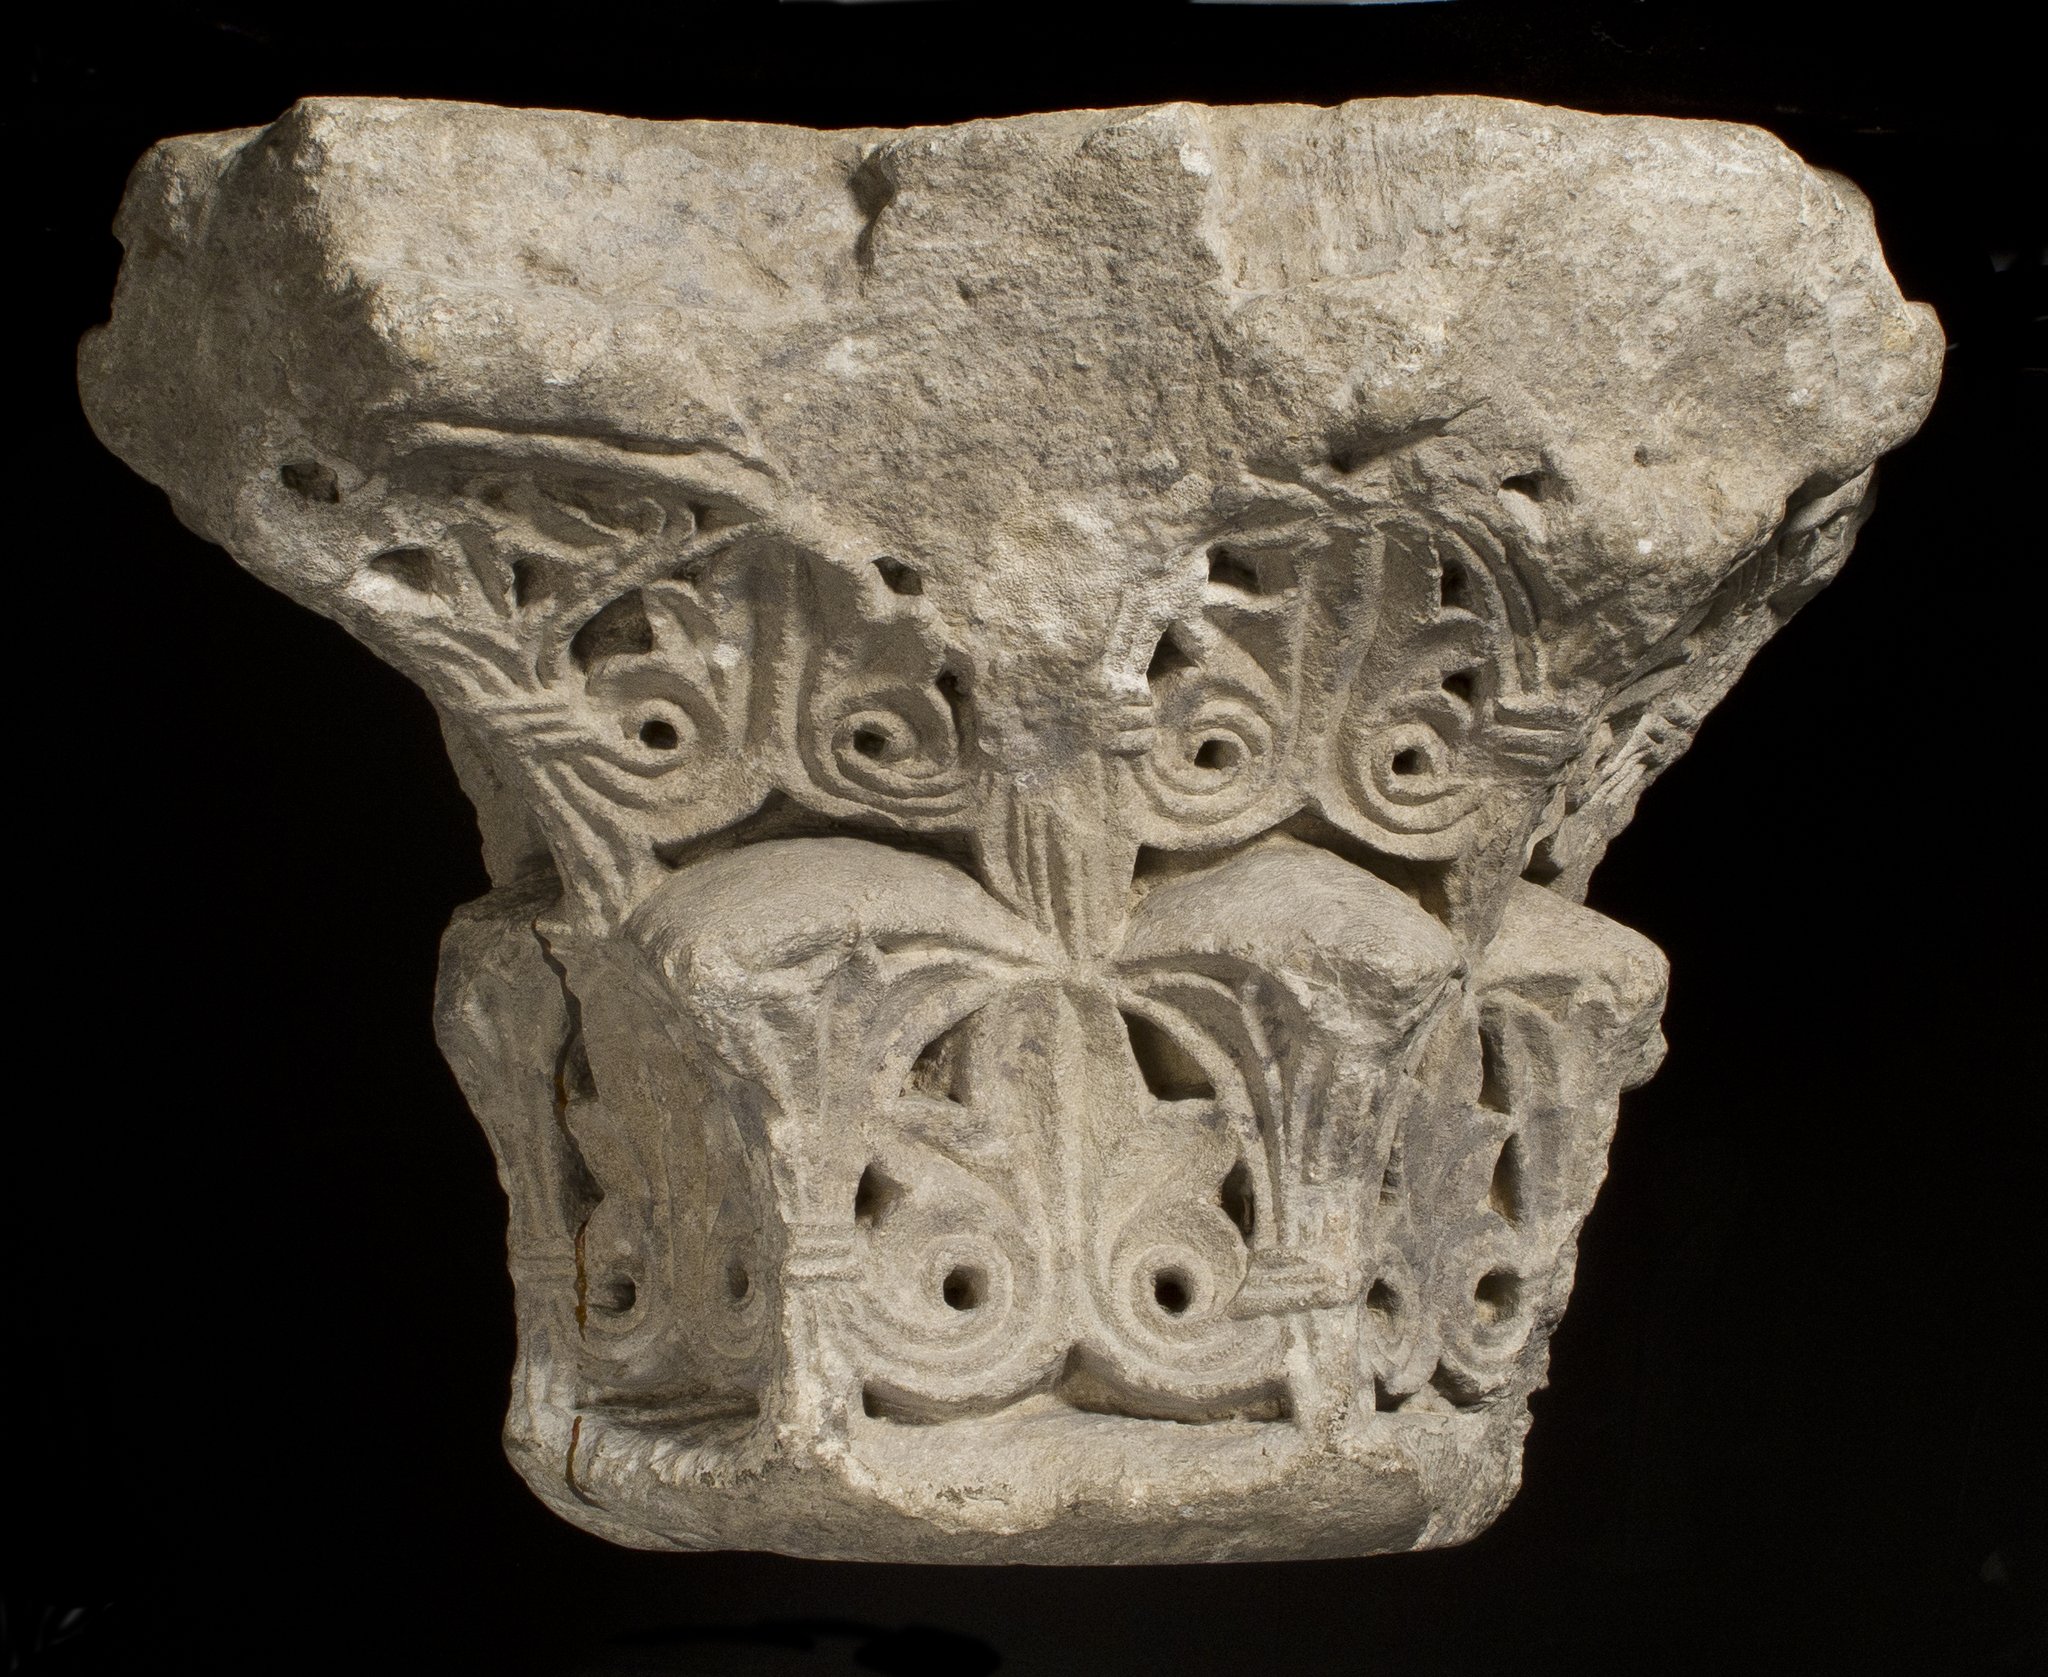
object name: capital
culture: french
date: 1101-1200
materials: stone